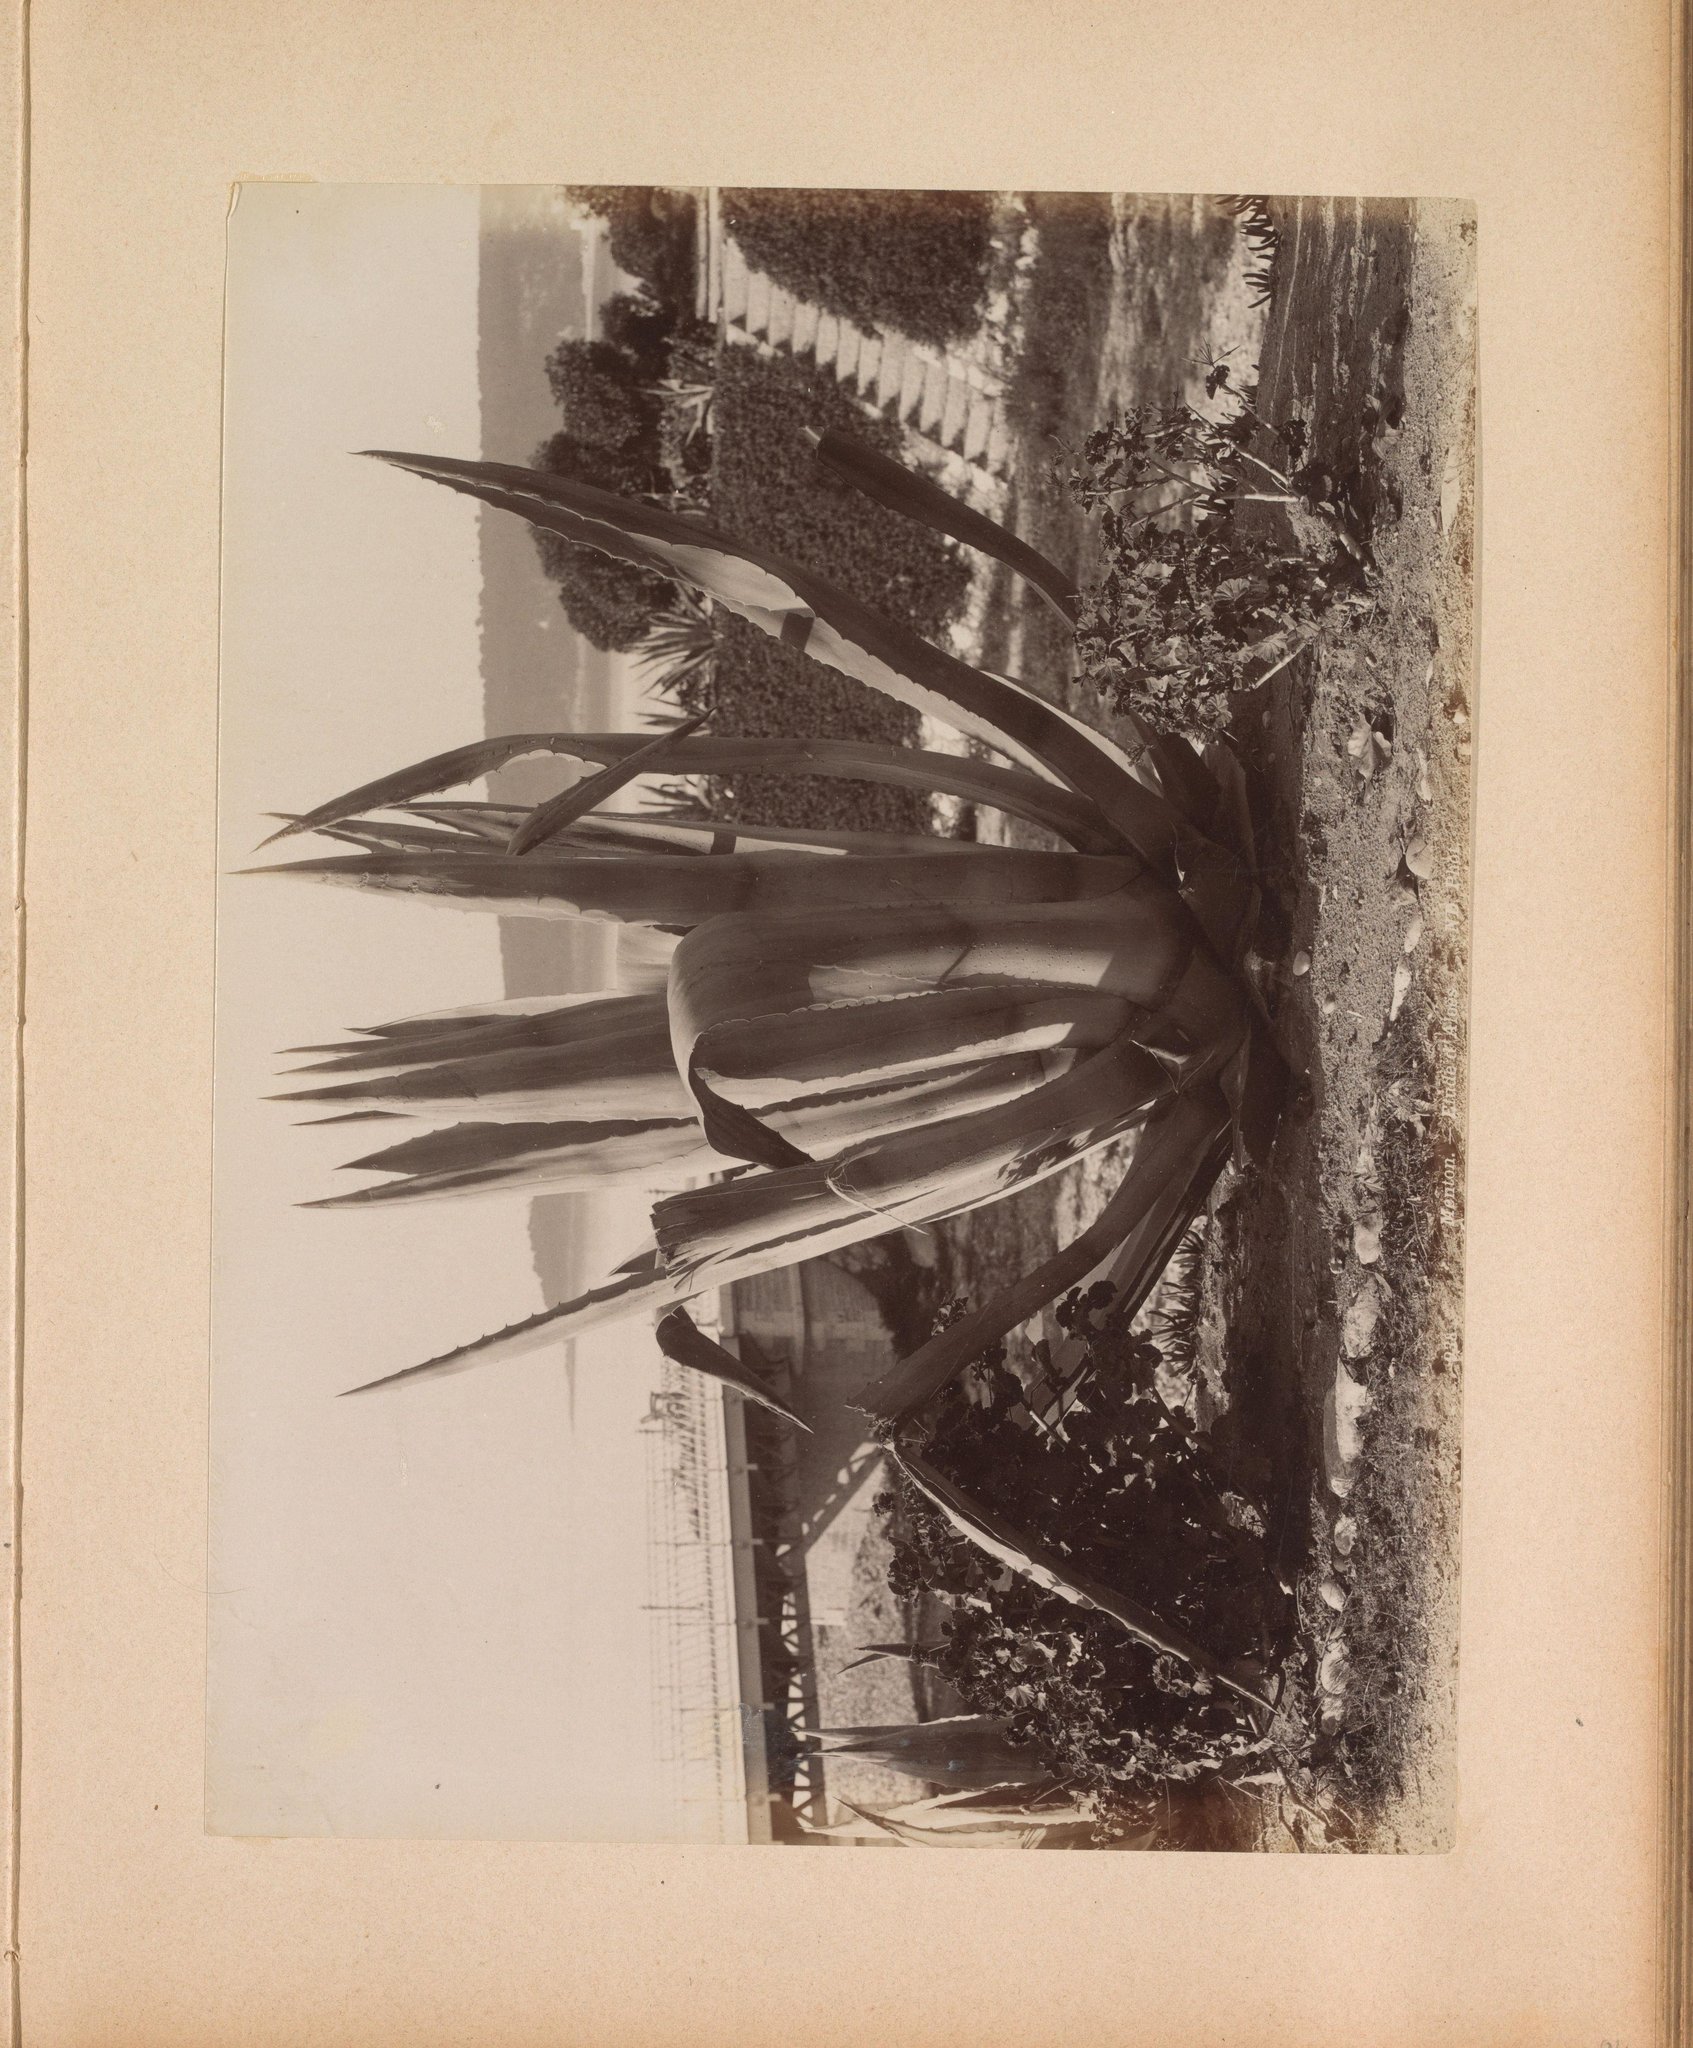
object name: photograph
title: Vetplant agave met op de achtergrond een brug in Menton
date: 1870-1900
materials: paper, photographic support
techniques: albumen print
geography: menton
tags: plants and herbs: agave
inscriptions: negative number: ‘938’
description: Onderdeel van Reisalbum met foto's van bezienswaardigheden in Italië en Zuid-Frankrijk.